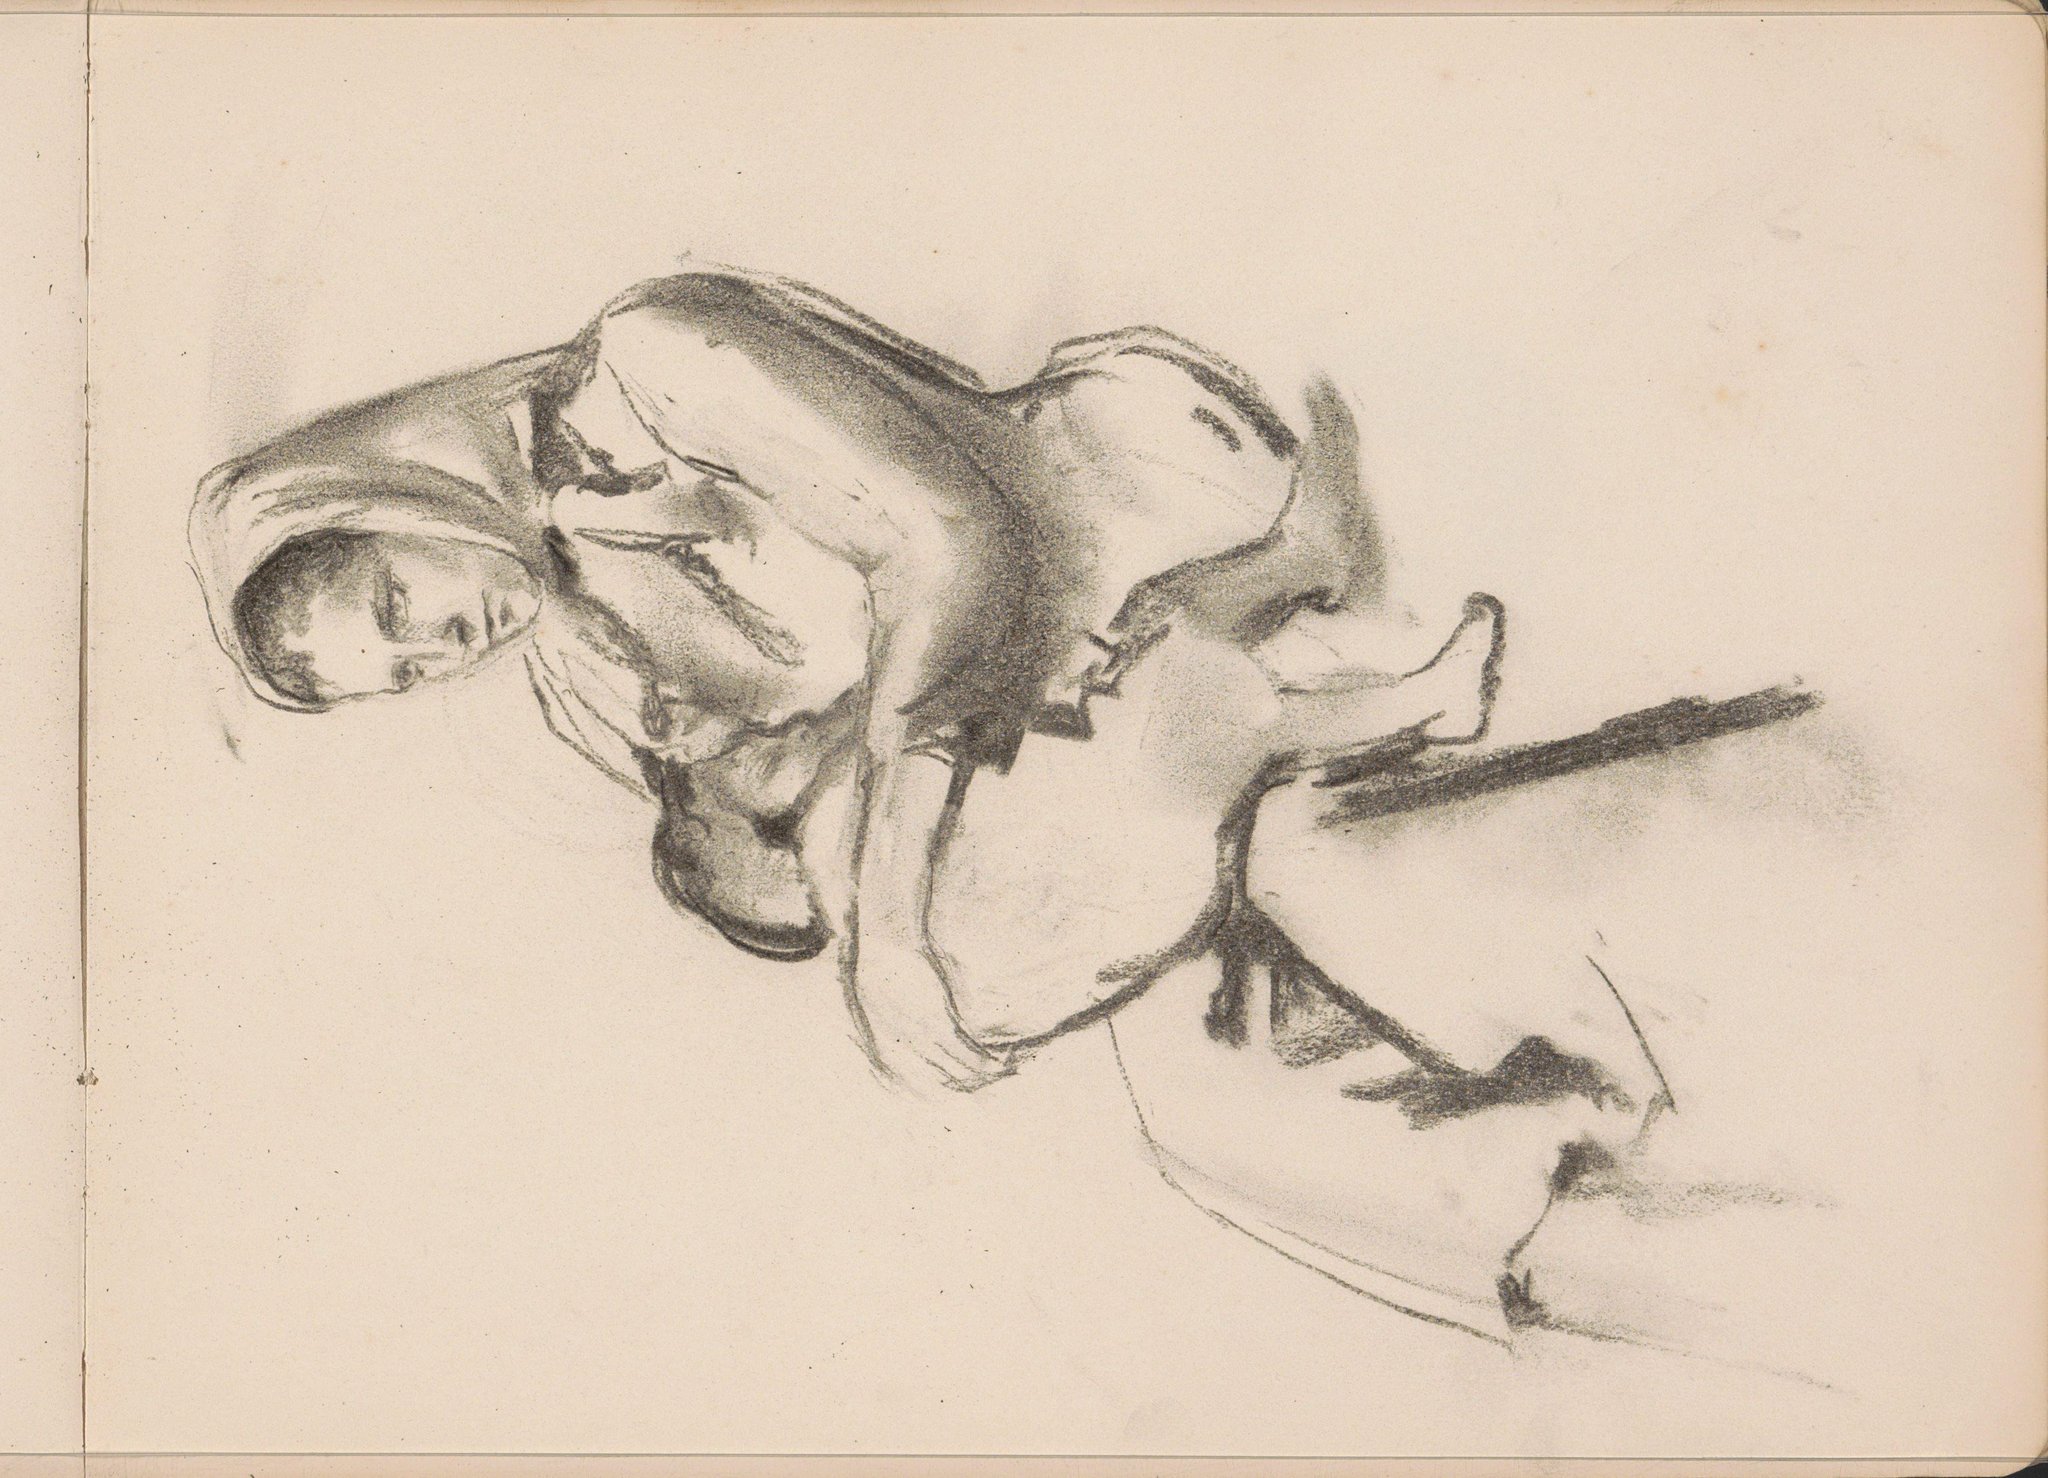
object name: sketchbook leaf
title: Moeder met een slapend kind op schoot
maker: a.a.l. de grammont-hubrecht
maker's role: draughtsman, painter, print maker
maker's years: 1855-1913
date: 1865-1913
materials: charcoal, paper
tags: sitting figure, mother and baby or young child, sleeping; unconsciousness, sitting in someone's lap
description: Blad 12 recto uit een schetsboek met 39 bladen.